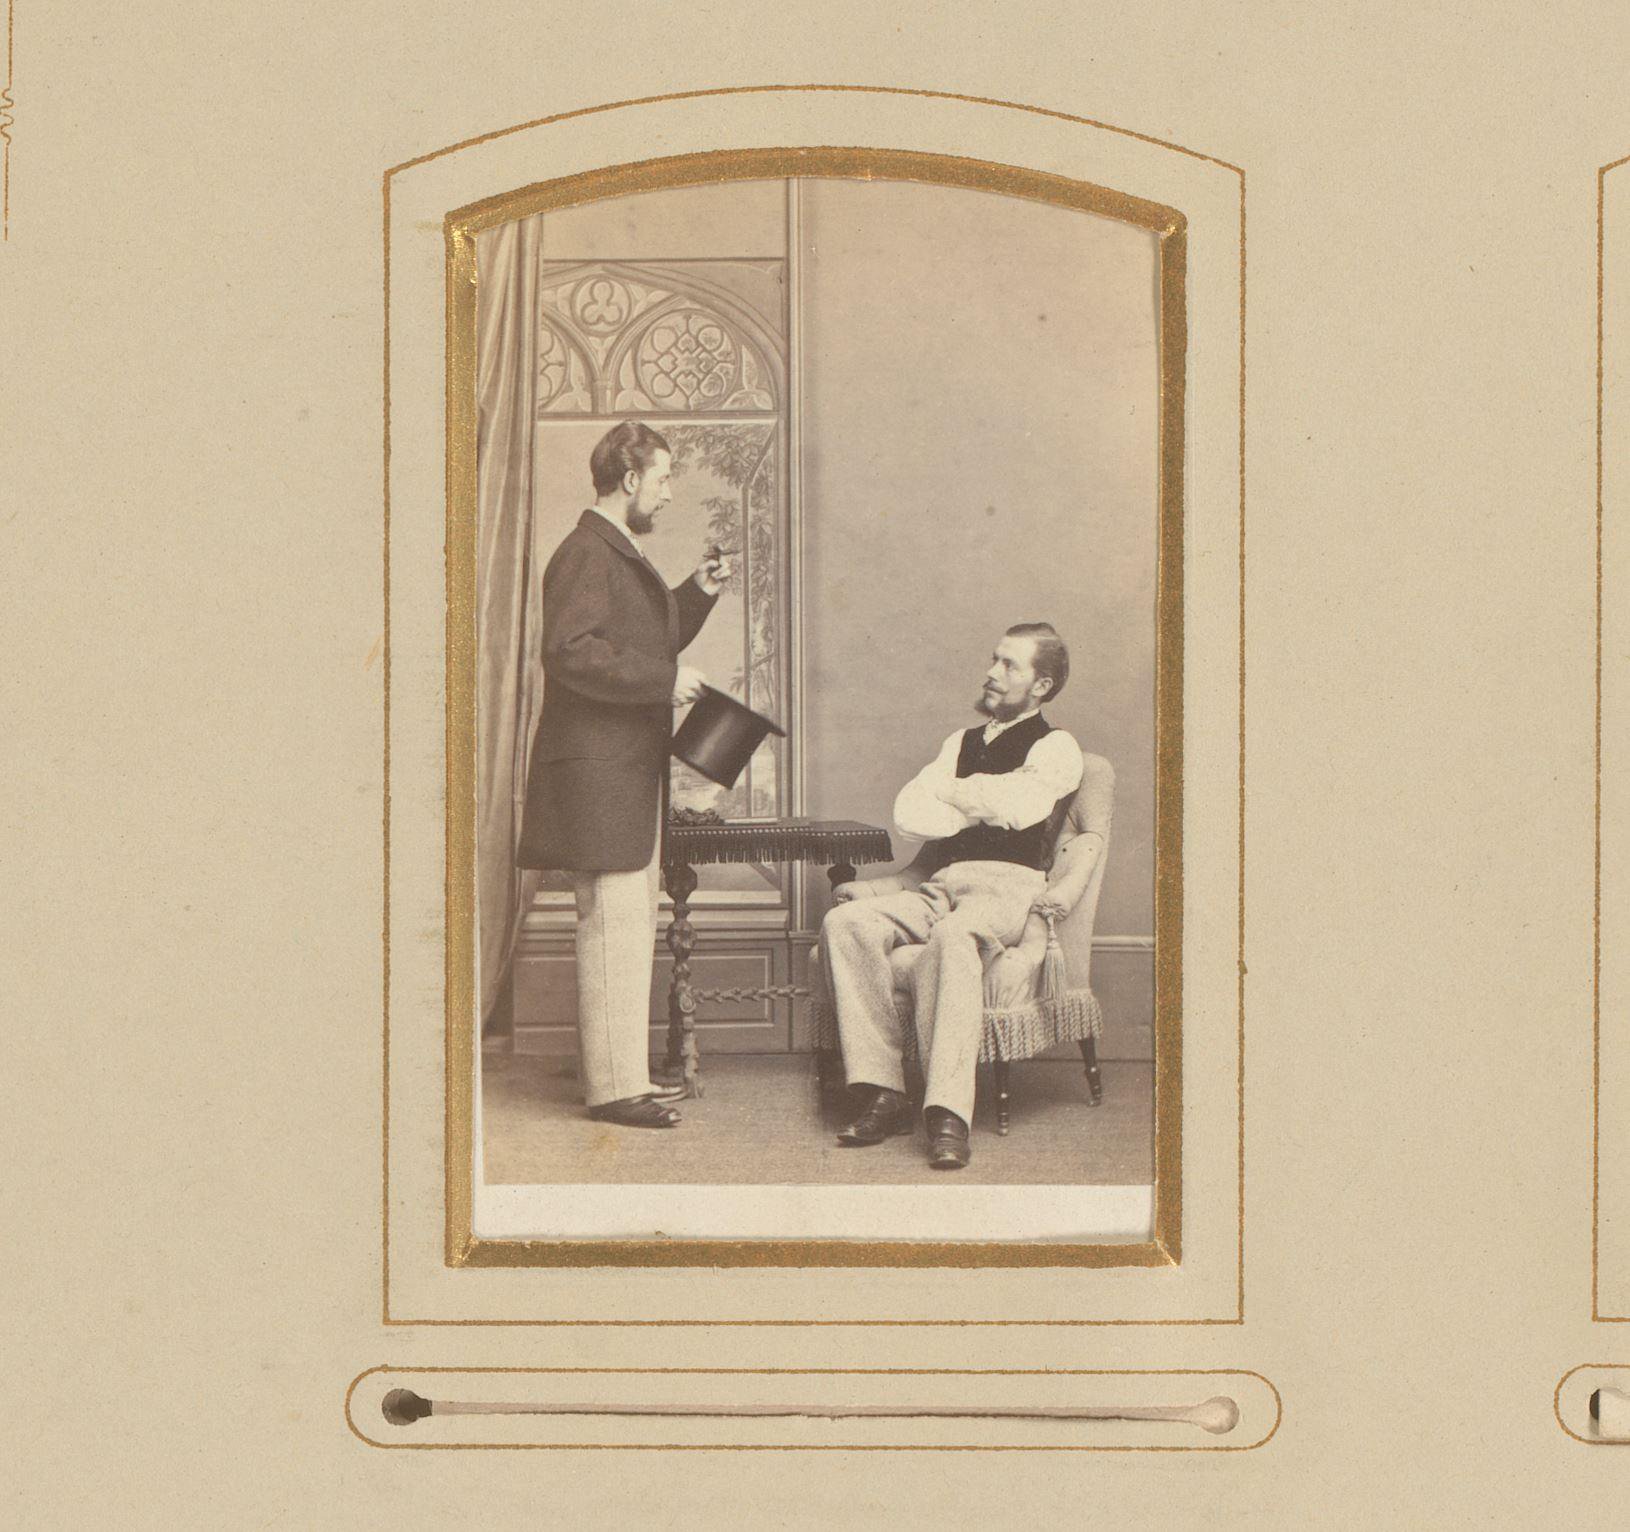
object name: photograph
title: Portret van twee mannen, waarvan één met hoge hoed in de hand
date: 1864-1868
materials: cardboard, photographic support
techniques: albumen print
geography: berlin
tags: adult man (+ two persons), historical persons, head-gear: top hat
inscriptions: inscription: ‘Photographische Gesellschaft/ BERLIN/ am Dönhofsplatz./ Abteilung für Portraits/ von/ GEBRÜDER GRUNDNER.’